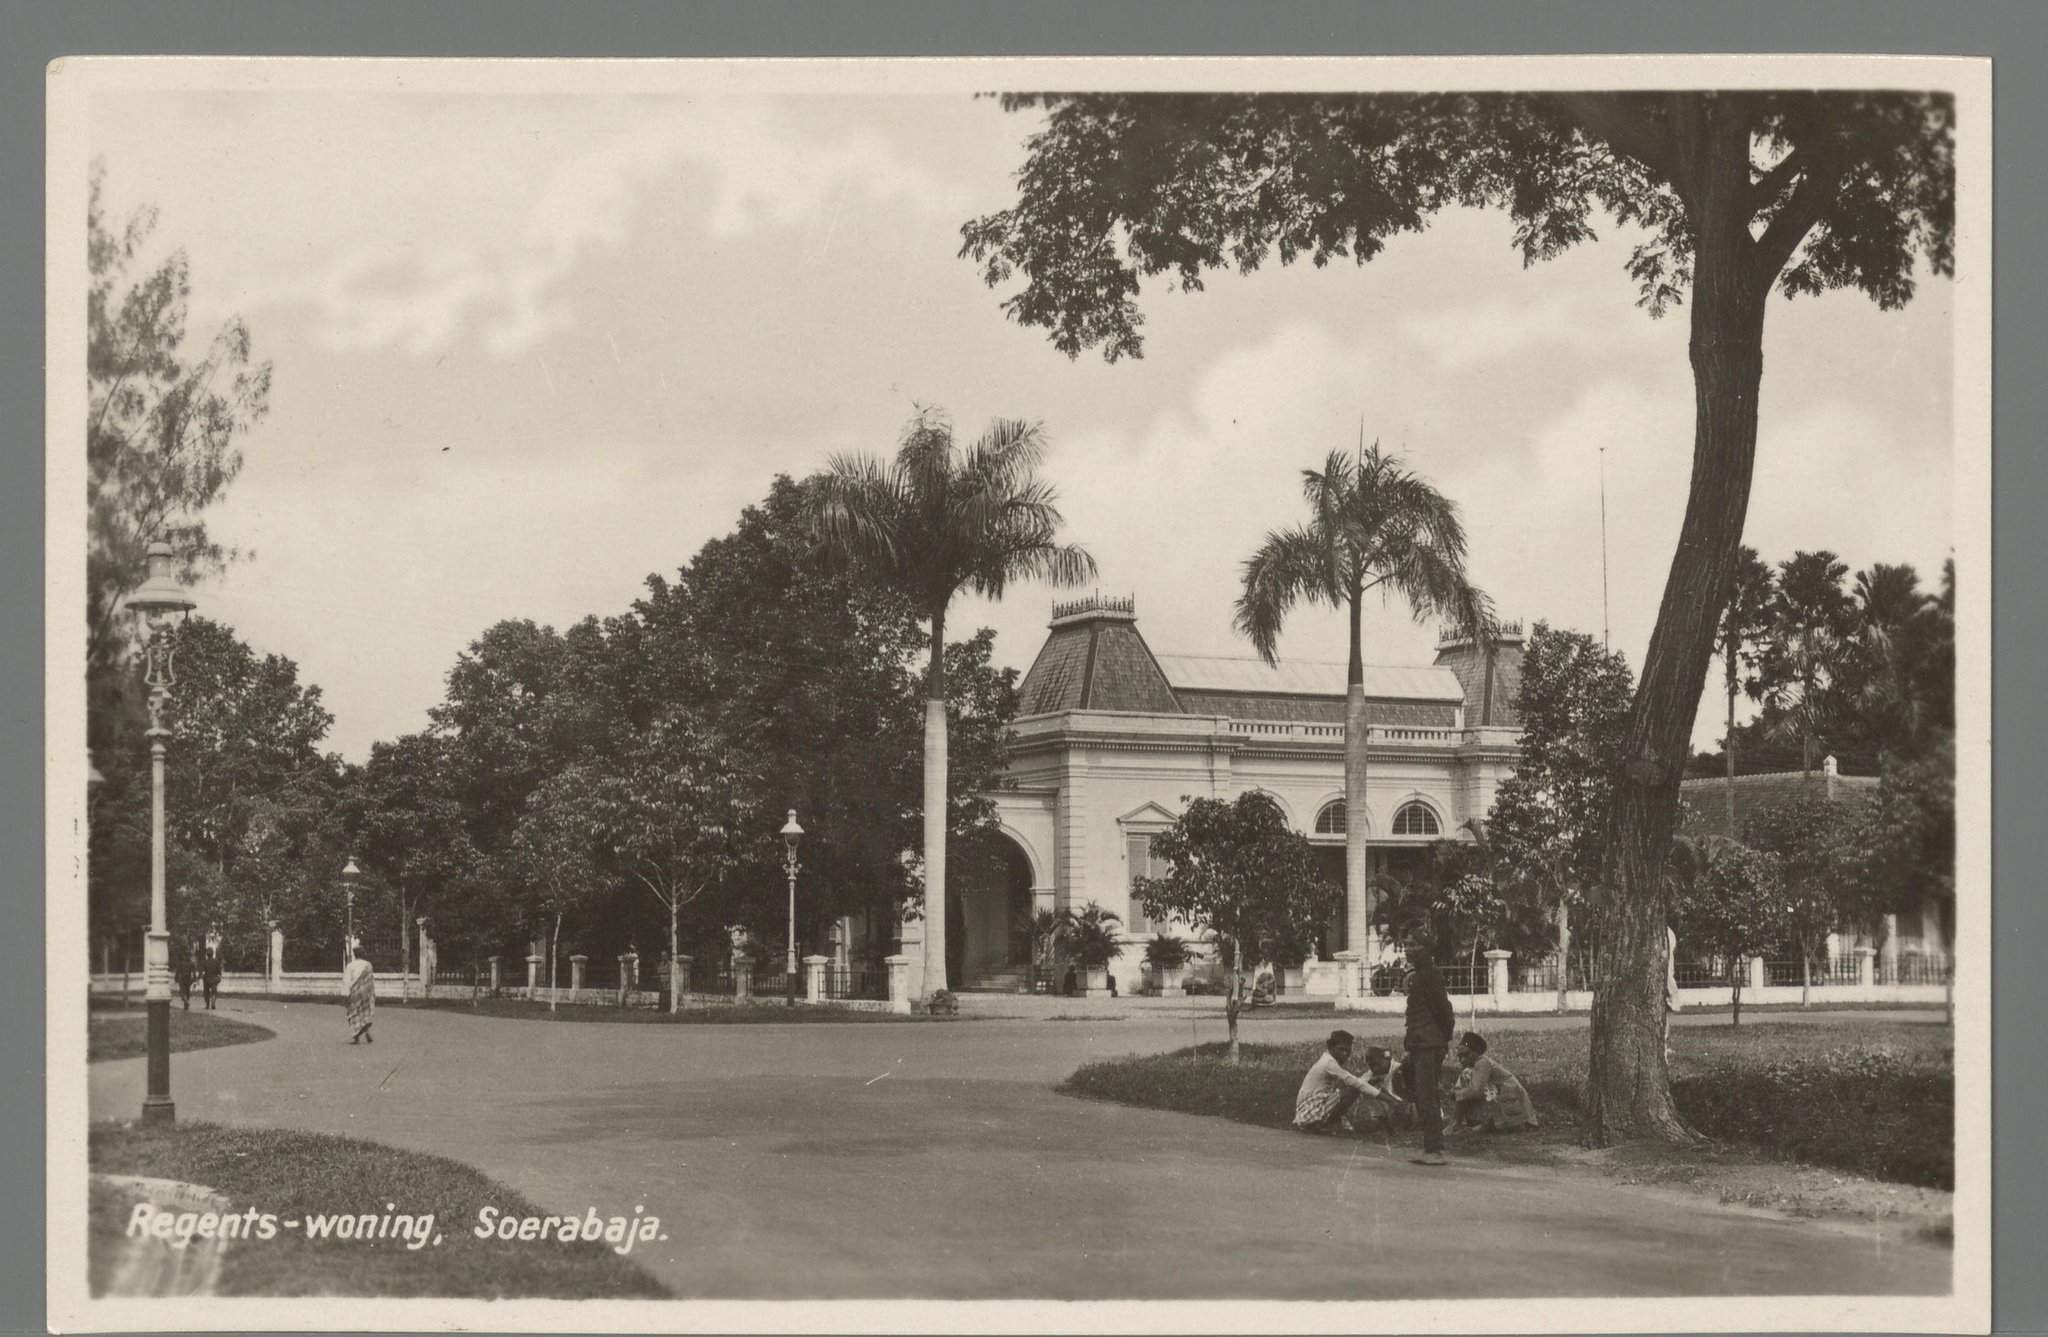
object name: ansichtkaart, prentbriefkaart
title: Regents-woning, Soerabaja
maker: Anonymous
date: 1919-1930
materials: paper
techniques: gelatin silver print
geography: surabaya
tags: villa, surabaya